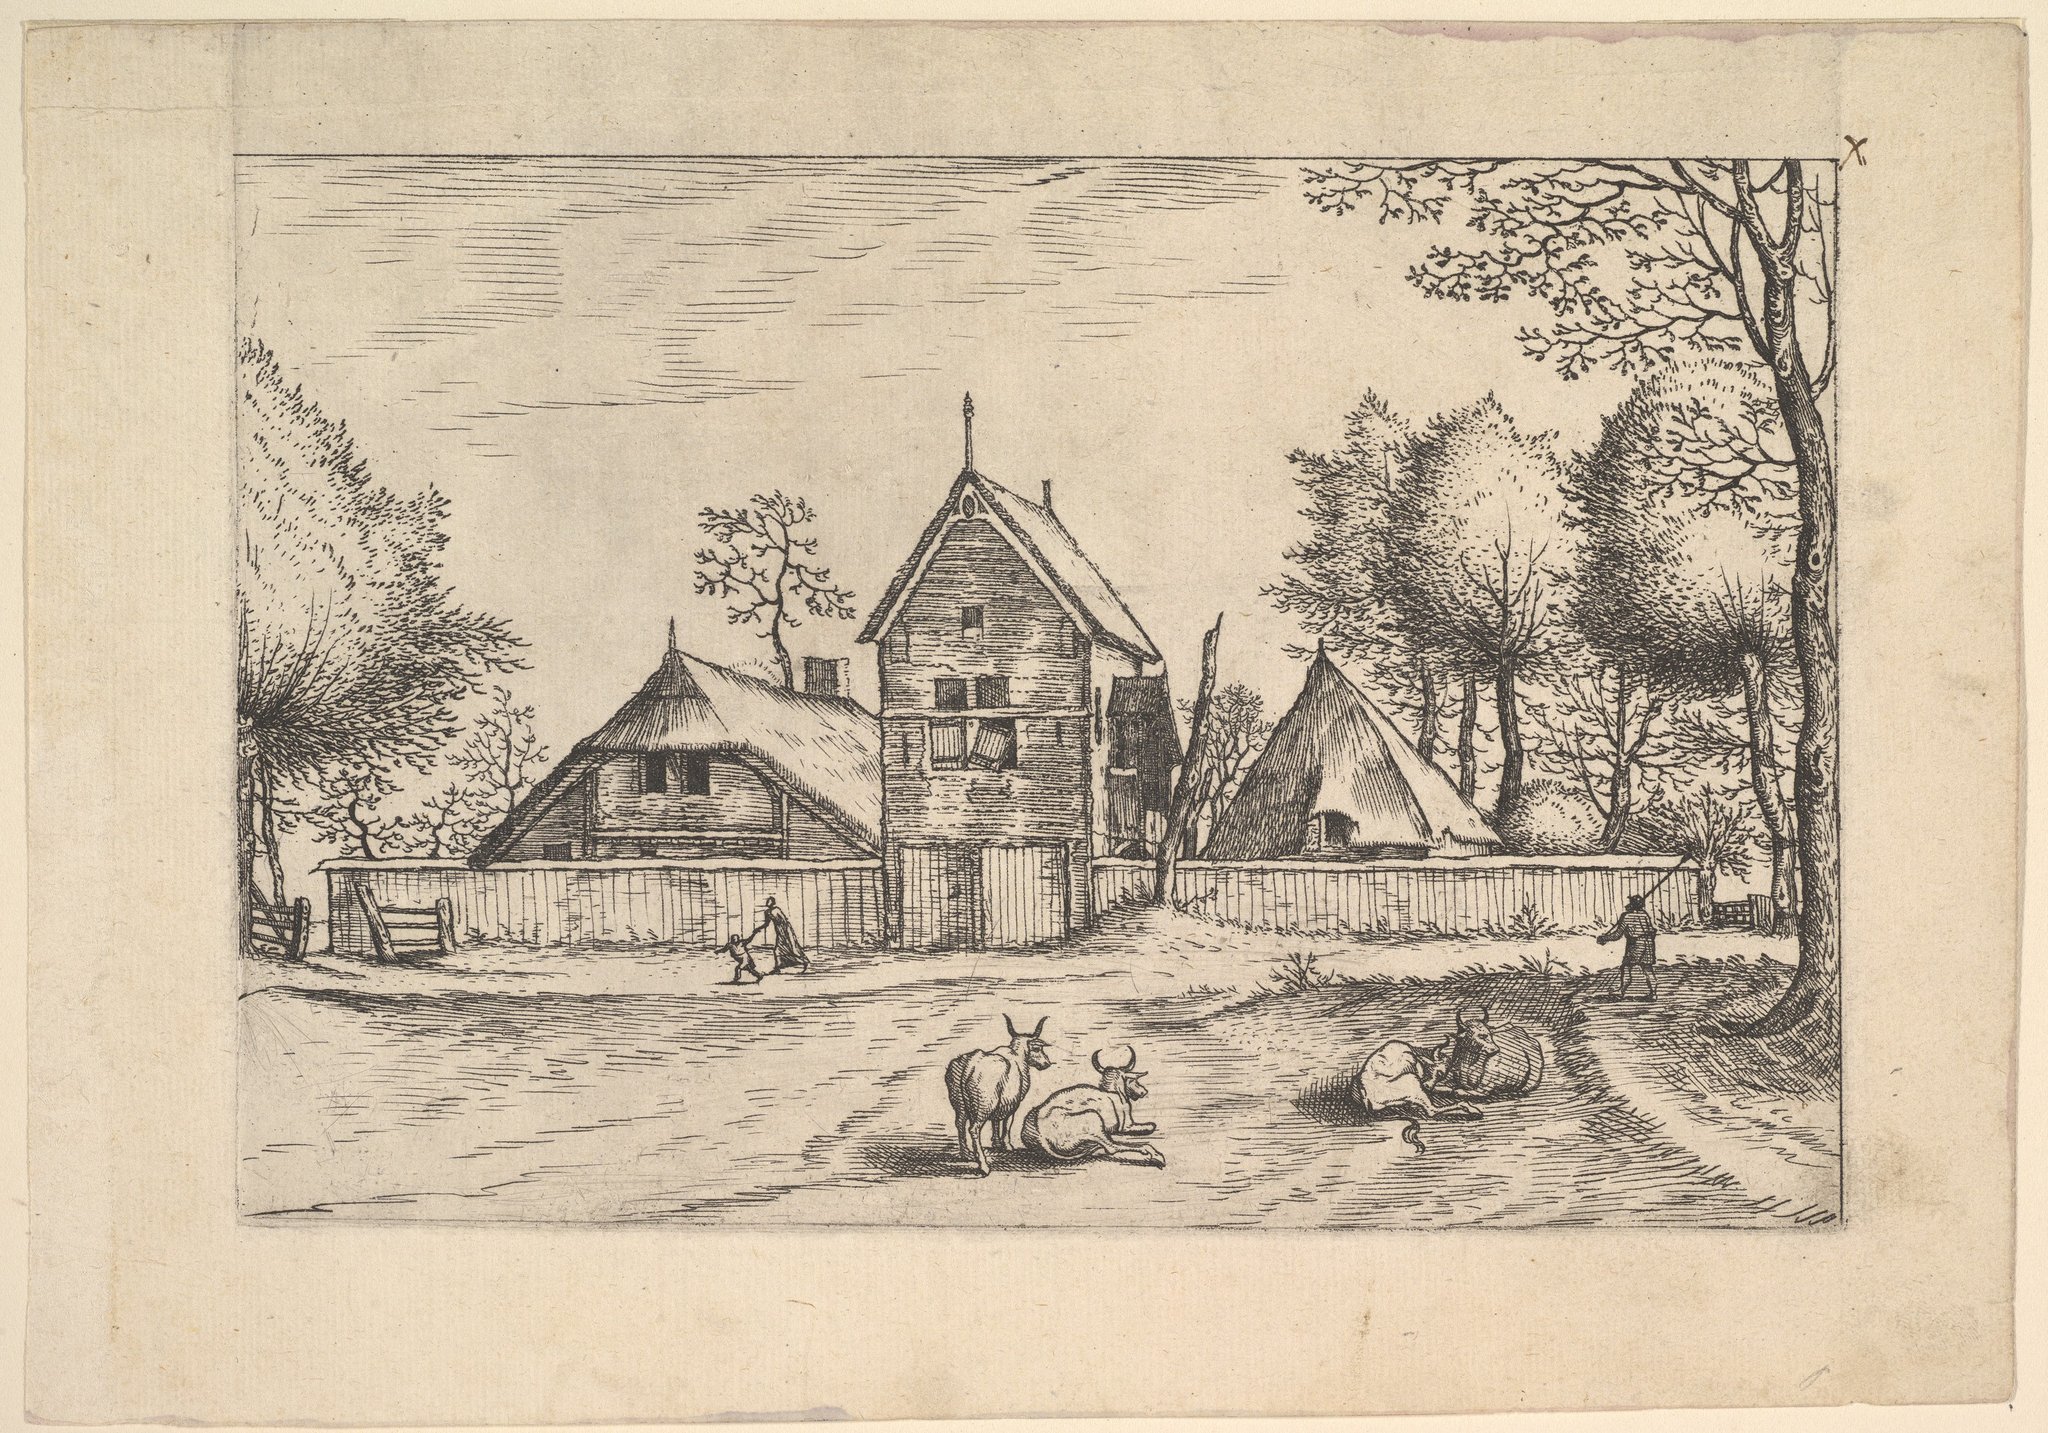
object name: print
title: Farmstead, cows and herdsman in the foreground from Praediorum villarum et rusticarum casularum icones elenoantissimae ad vivum in apre deformatae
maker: johannes van doetecum i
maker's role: artist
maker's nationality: netherlandish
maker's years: 1528-1605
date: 1559-1561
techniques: etching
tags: farms,men,agriculture,cows,trees